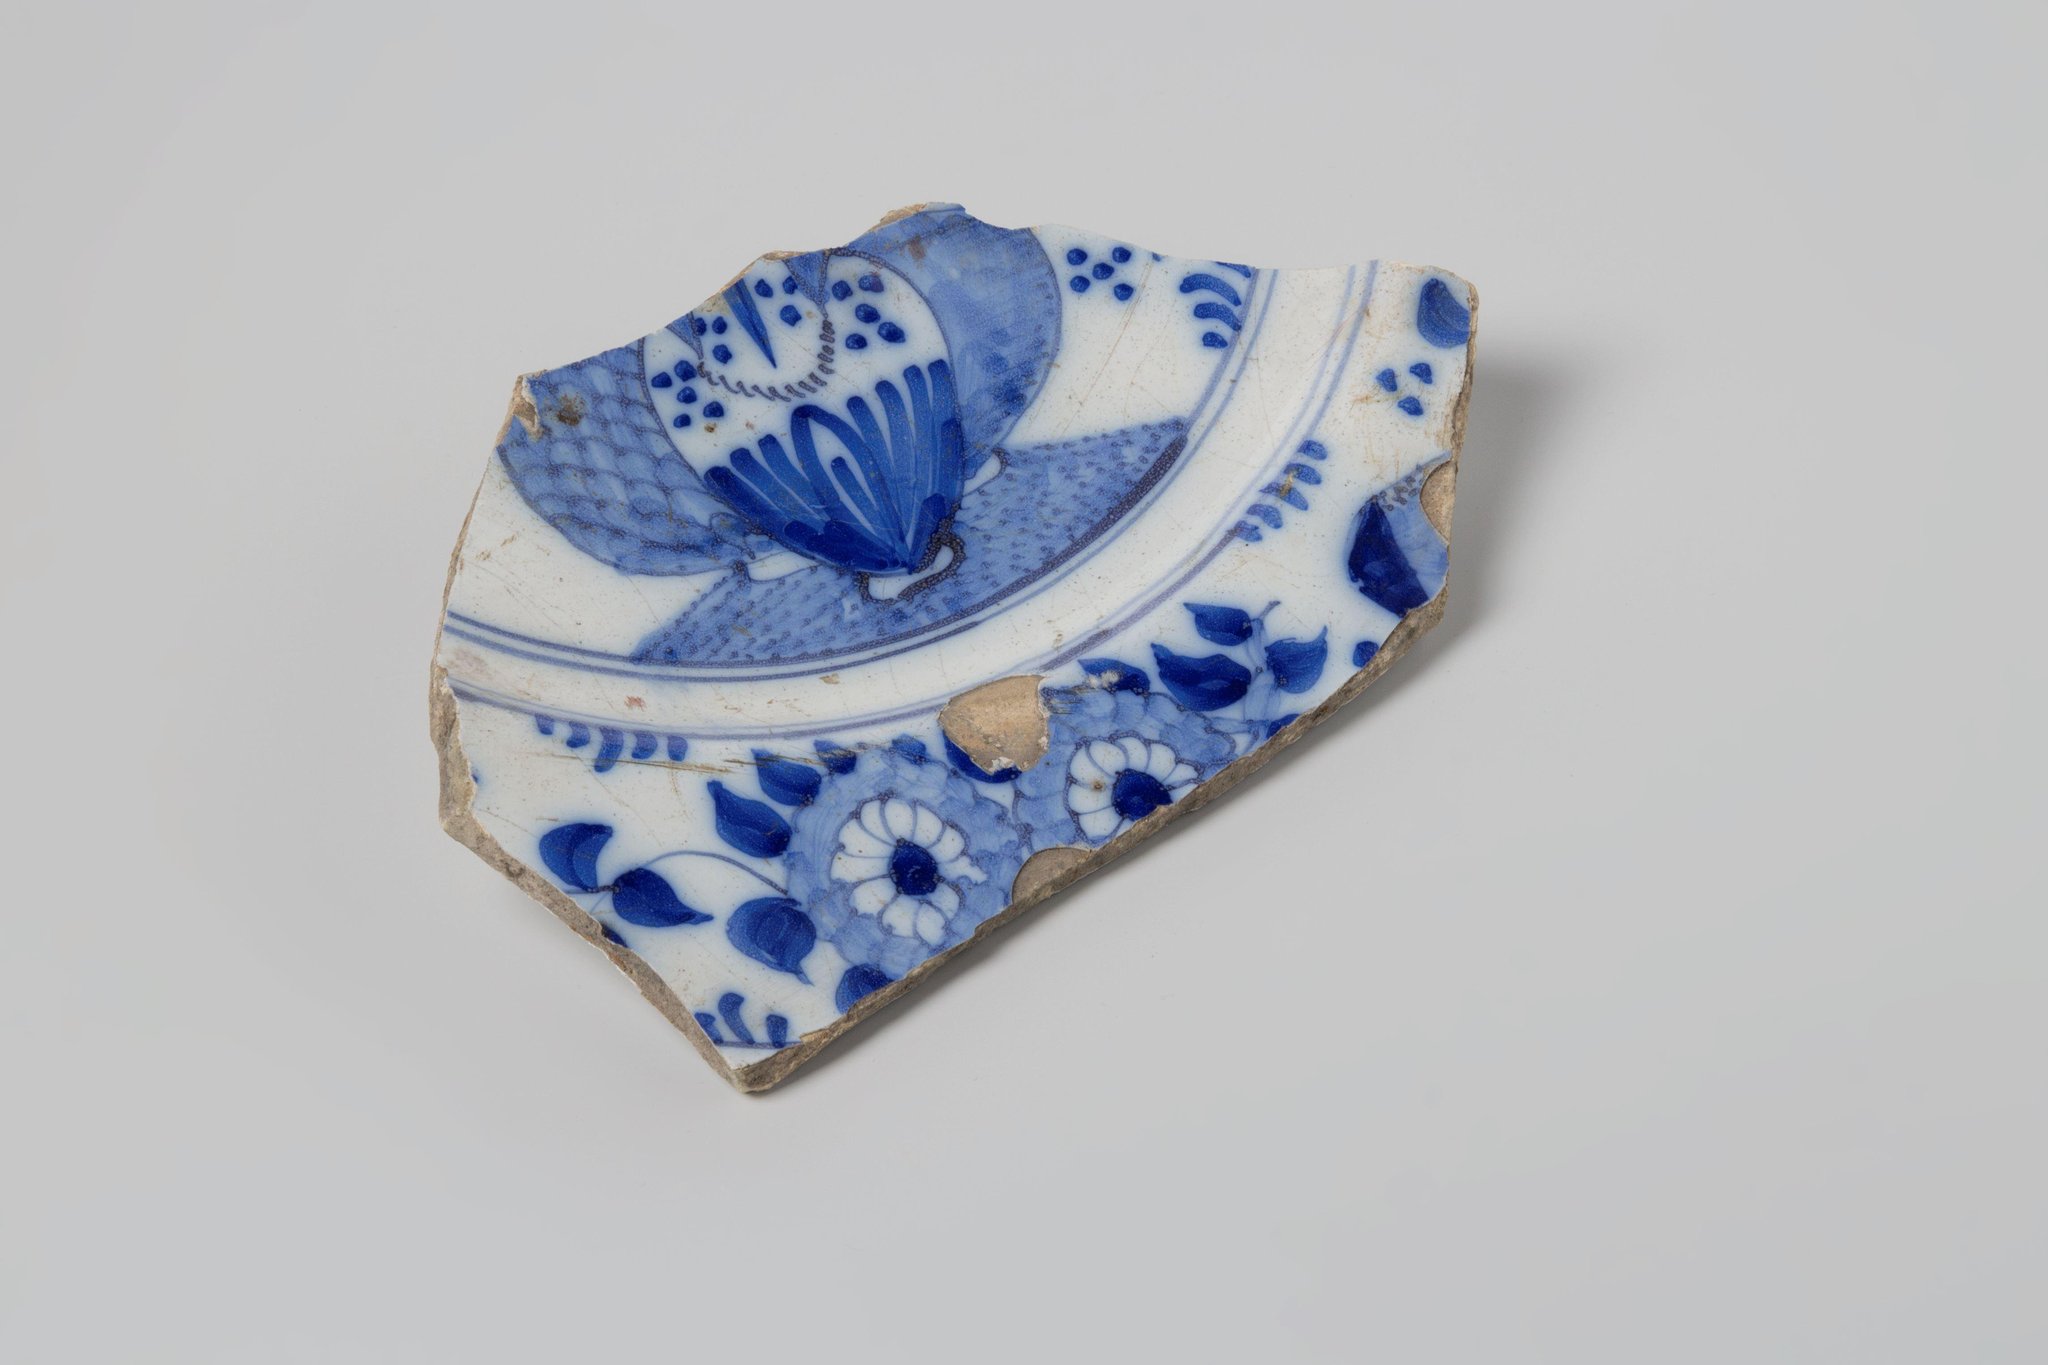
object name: sherd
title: Schotelscherf van aardewerk met aan de achterzijde wit tinglazuur en aan de voorzijde tinglazuur en een decoratie van onder andere bloemen in blauw, beschadigd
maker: Anonymous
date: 1500-1799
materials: earthenware, glaze